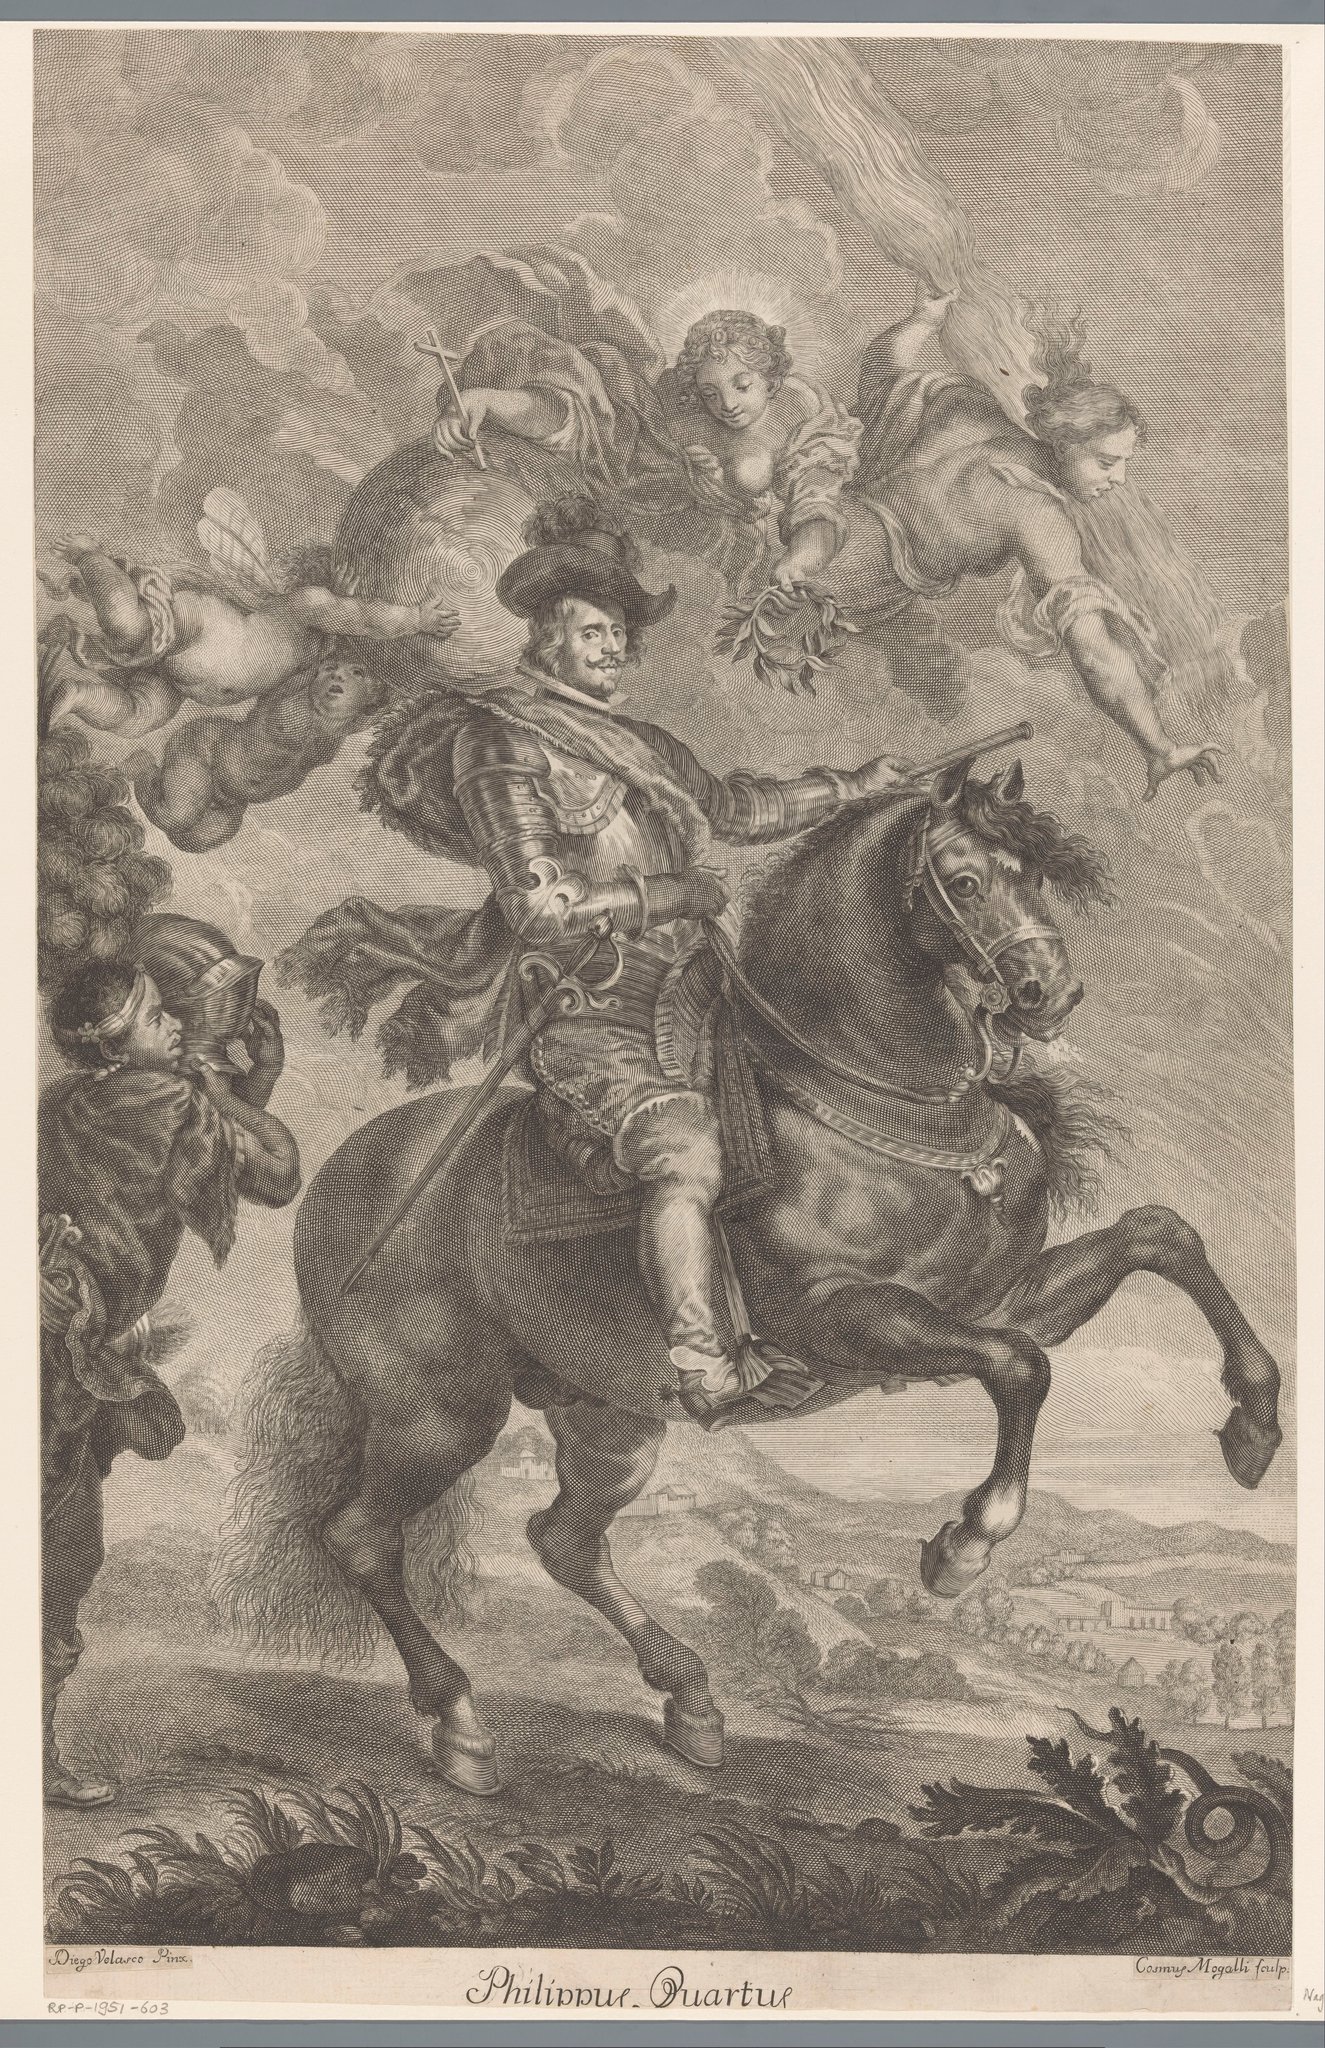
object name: print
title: Ruiterportret van Filips IV van Spanje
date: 1677-1730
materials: paper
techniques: engraving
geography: italy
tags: filips iv (koning van spanje), equestrian state-portrait, historical persons, ruler, sovereign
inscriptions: collector's mark: Lugt 2228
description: Naar een schilderij door Velázquez in de Galleria degli Uffizi te Florence.